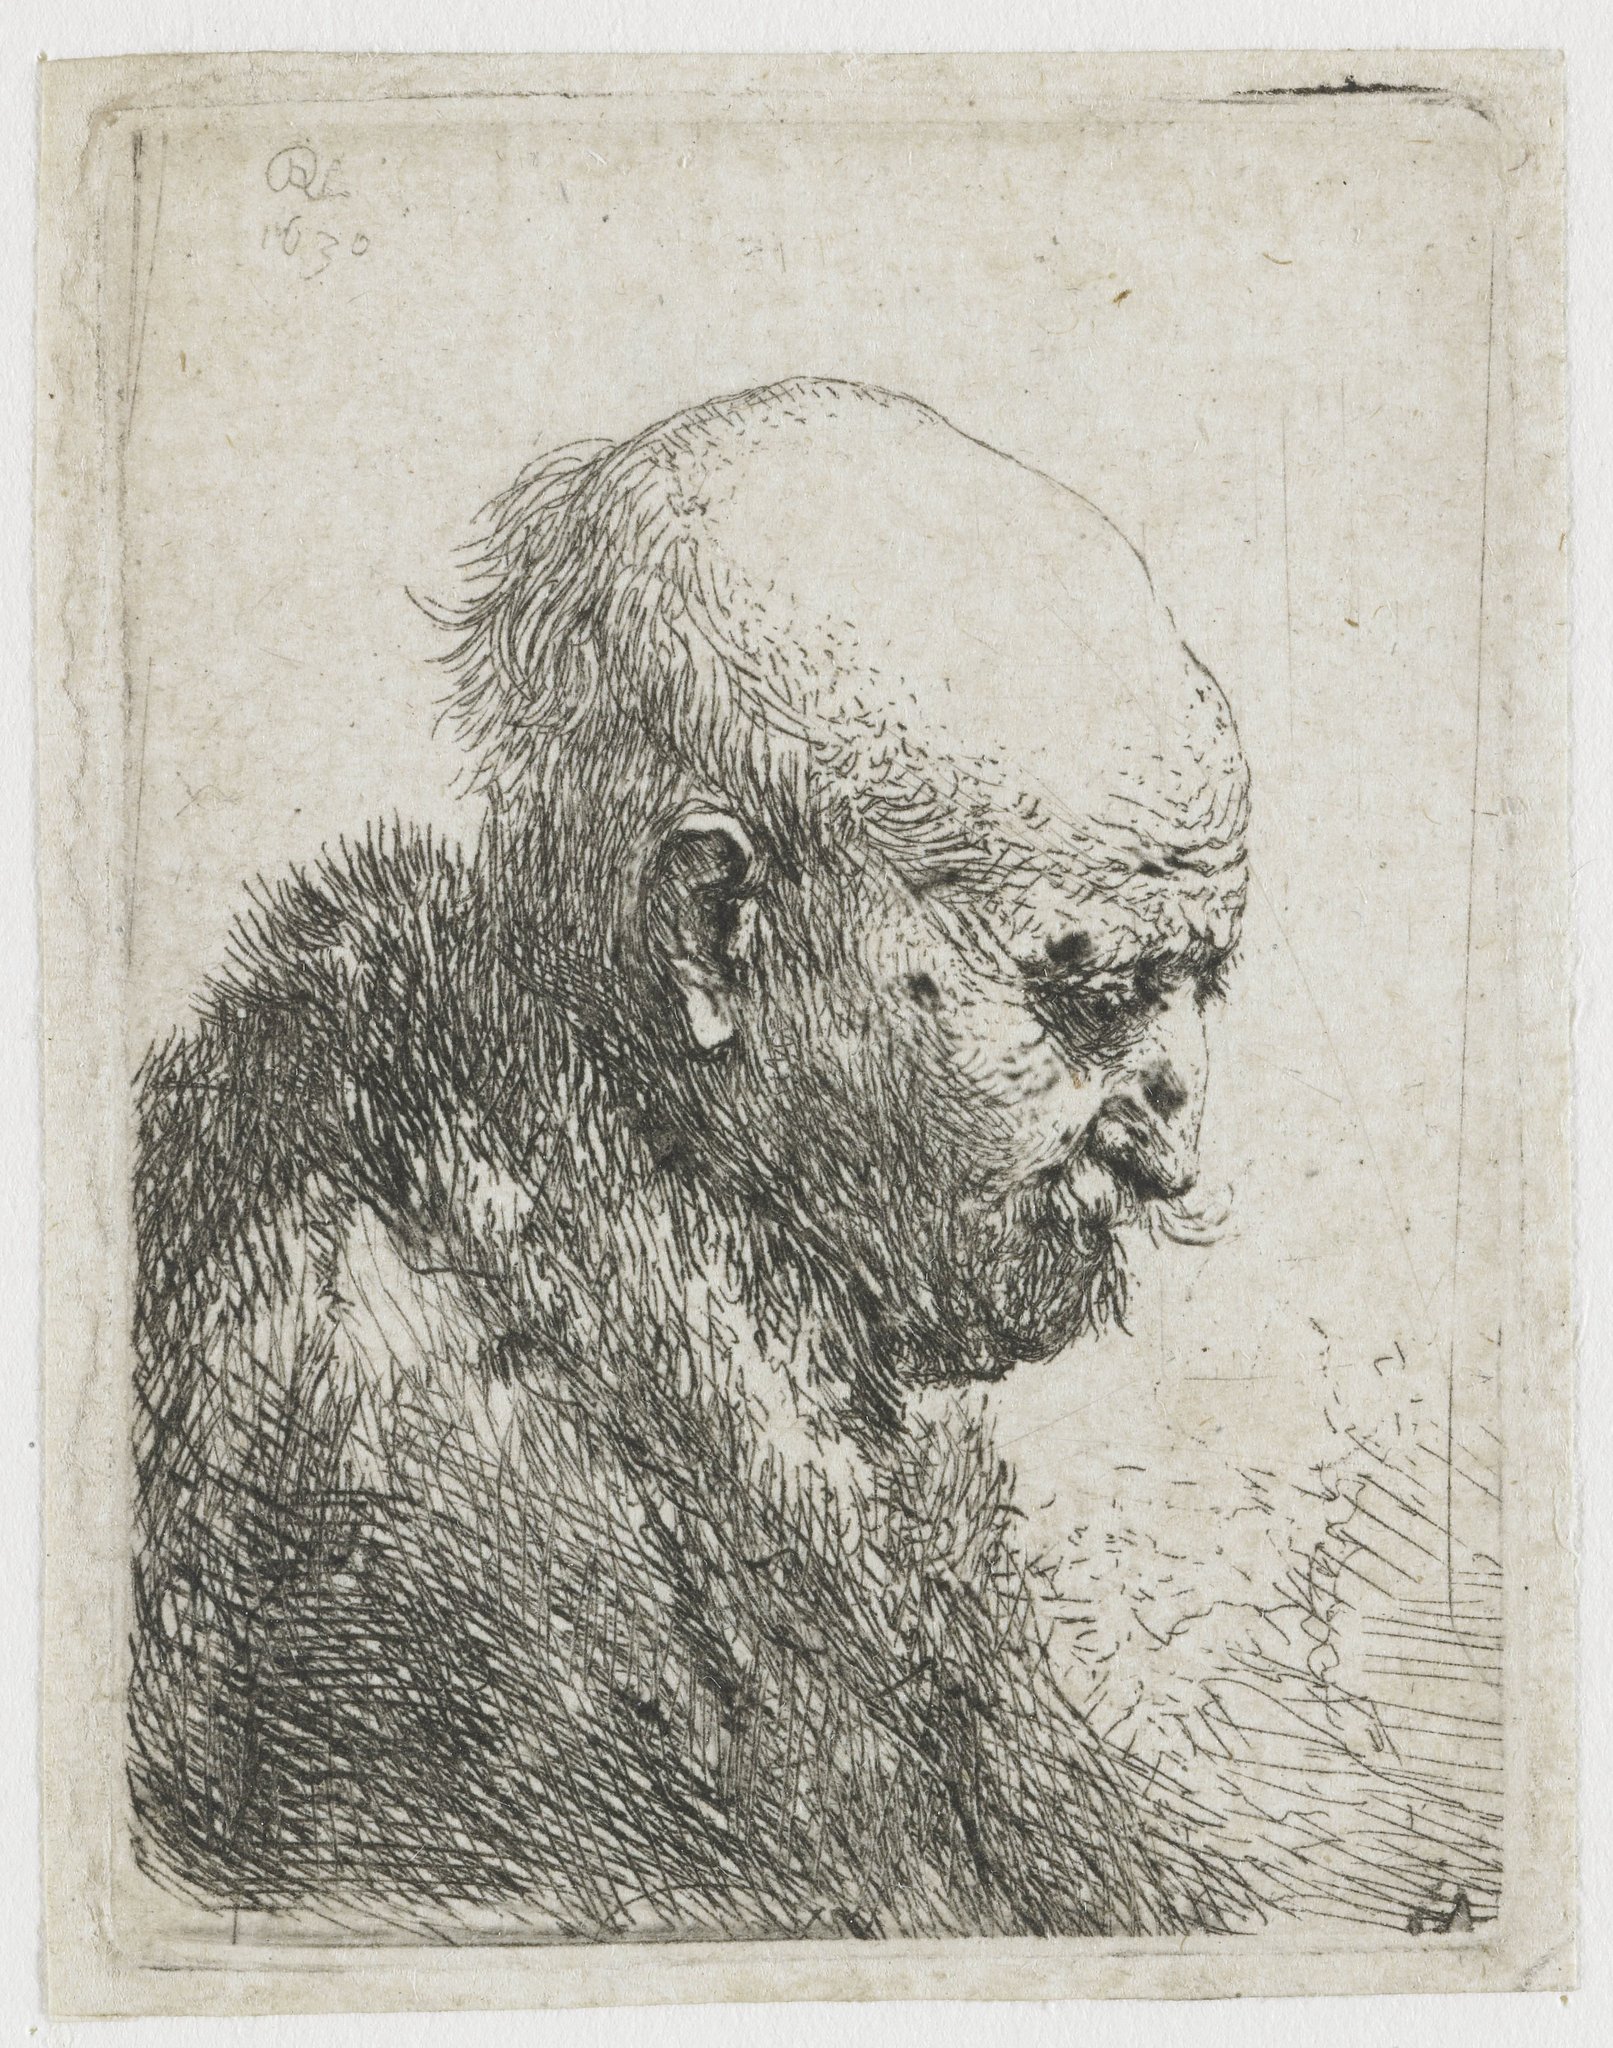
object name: print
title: Bald headed man in profile right: small bust, the artist's father (?)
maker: rembrandt van rijn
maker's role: draughtsman, painter, print maker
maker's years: 1606-1669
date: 1630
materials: paper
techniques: etching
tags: leiden, can hook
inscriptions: monogram and date: ‘RHL 1630’, collector's mark: Lugt 2228